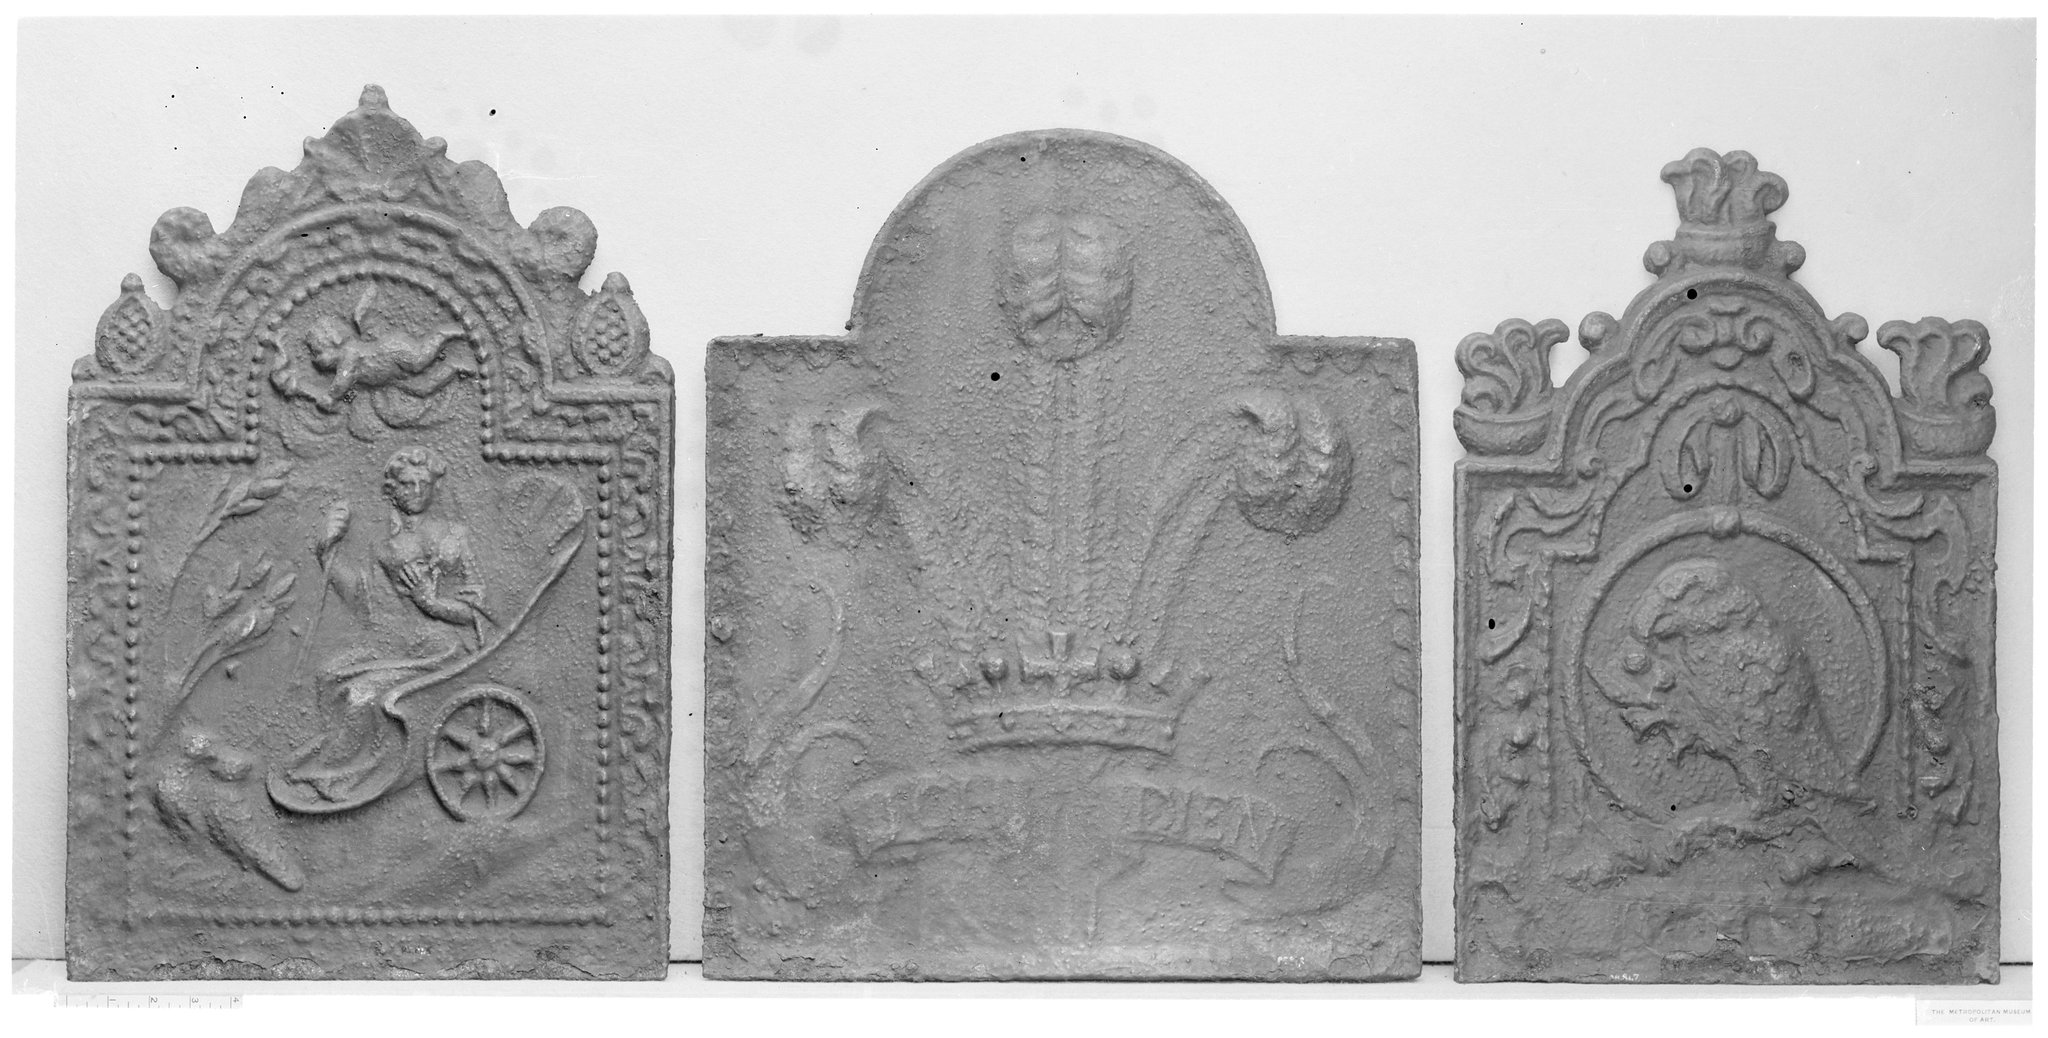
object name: fireback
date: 1701-1800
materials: iron